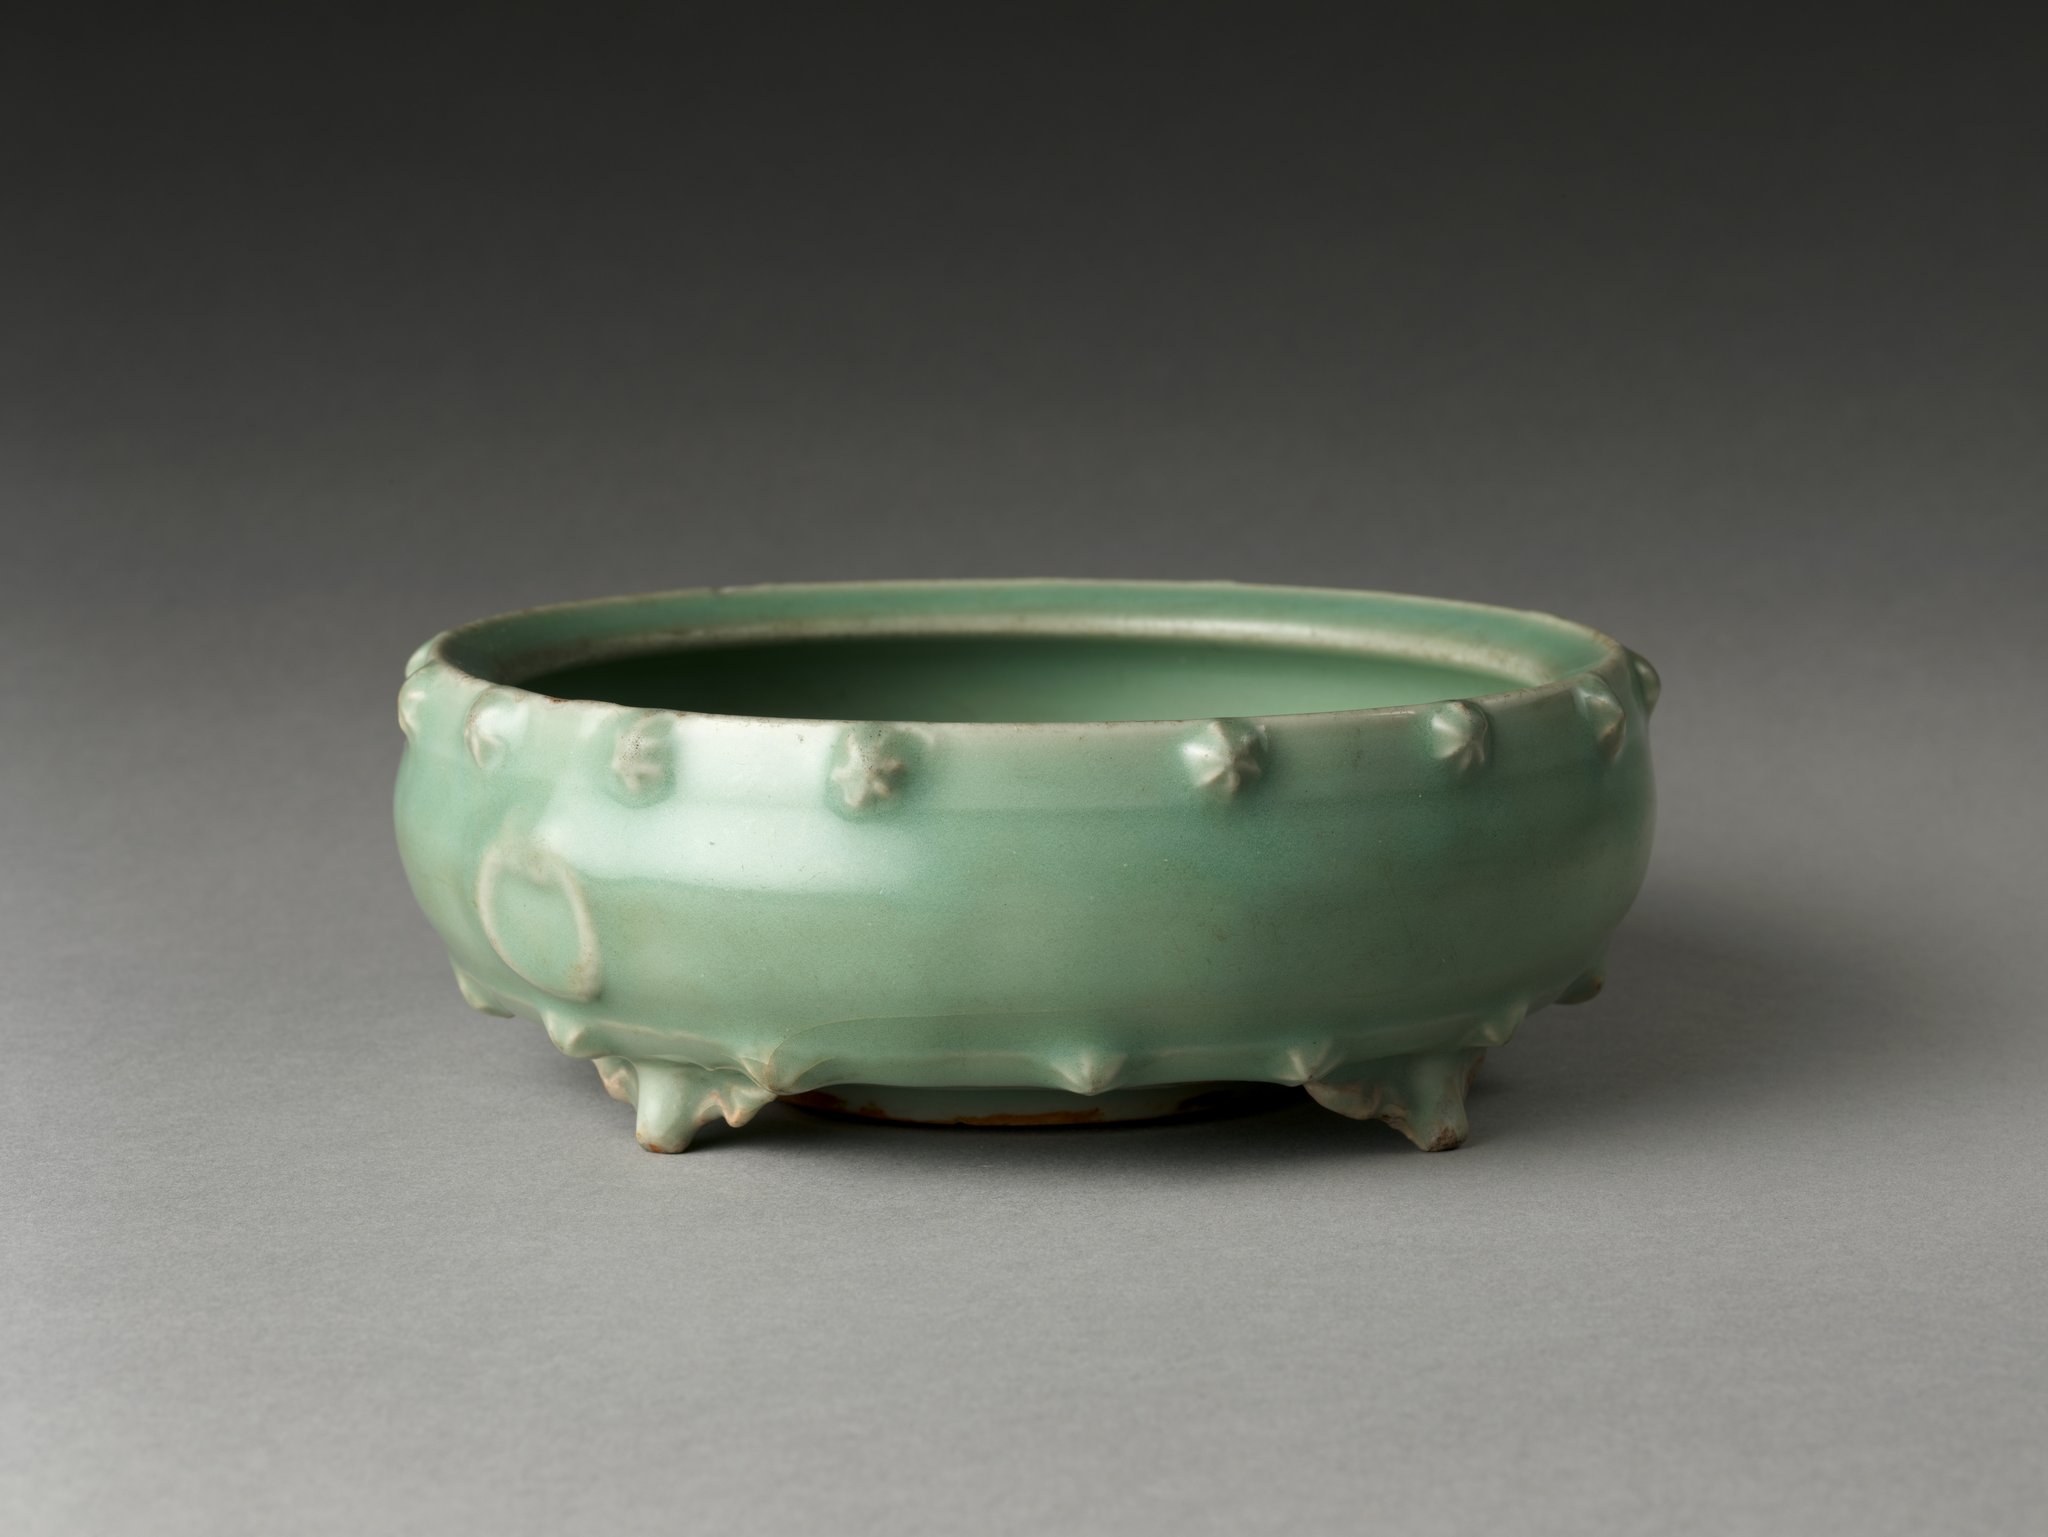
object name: container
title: Container for Bulbs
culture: chinese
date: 1201-1333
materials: ceramic glaze, glaze, stoneware